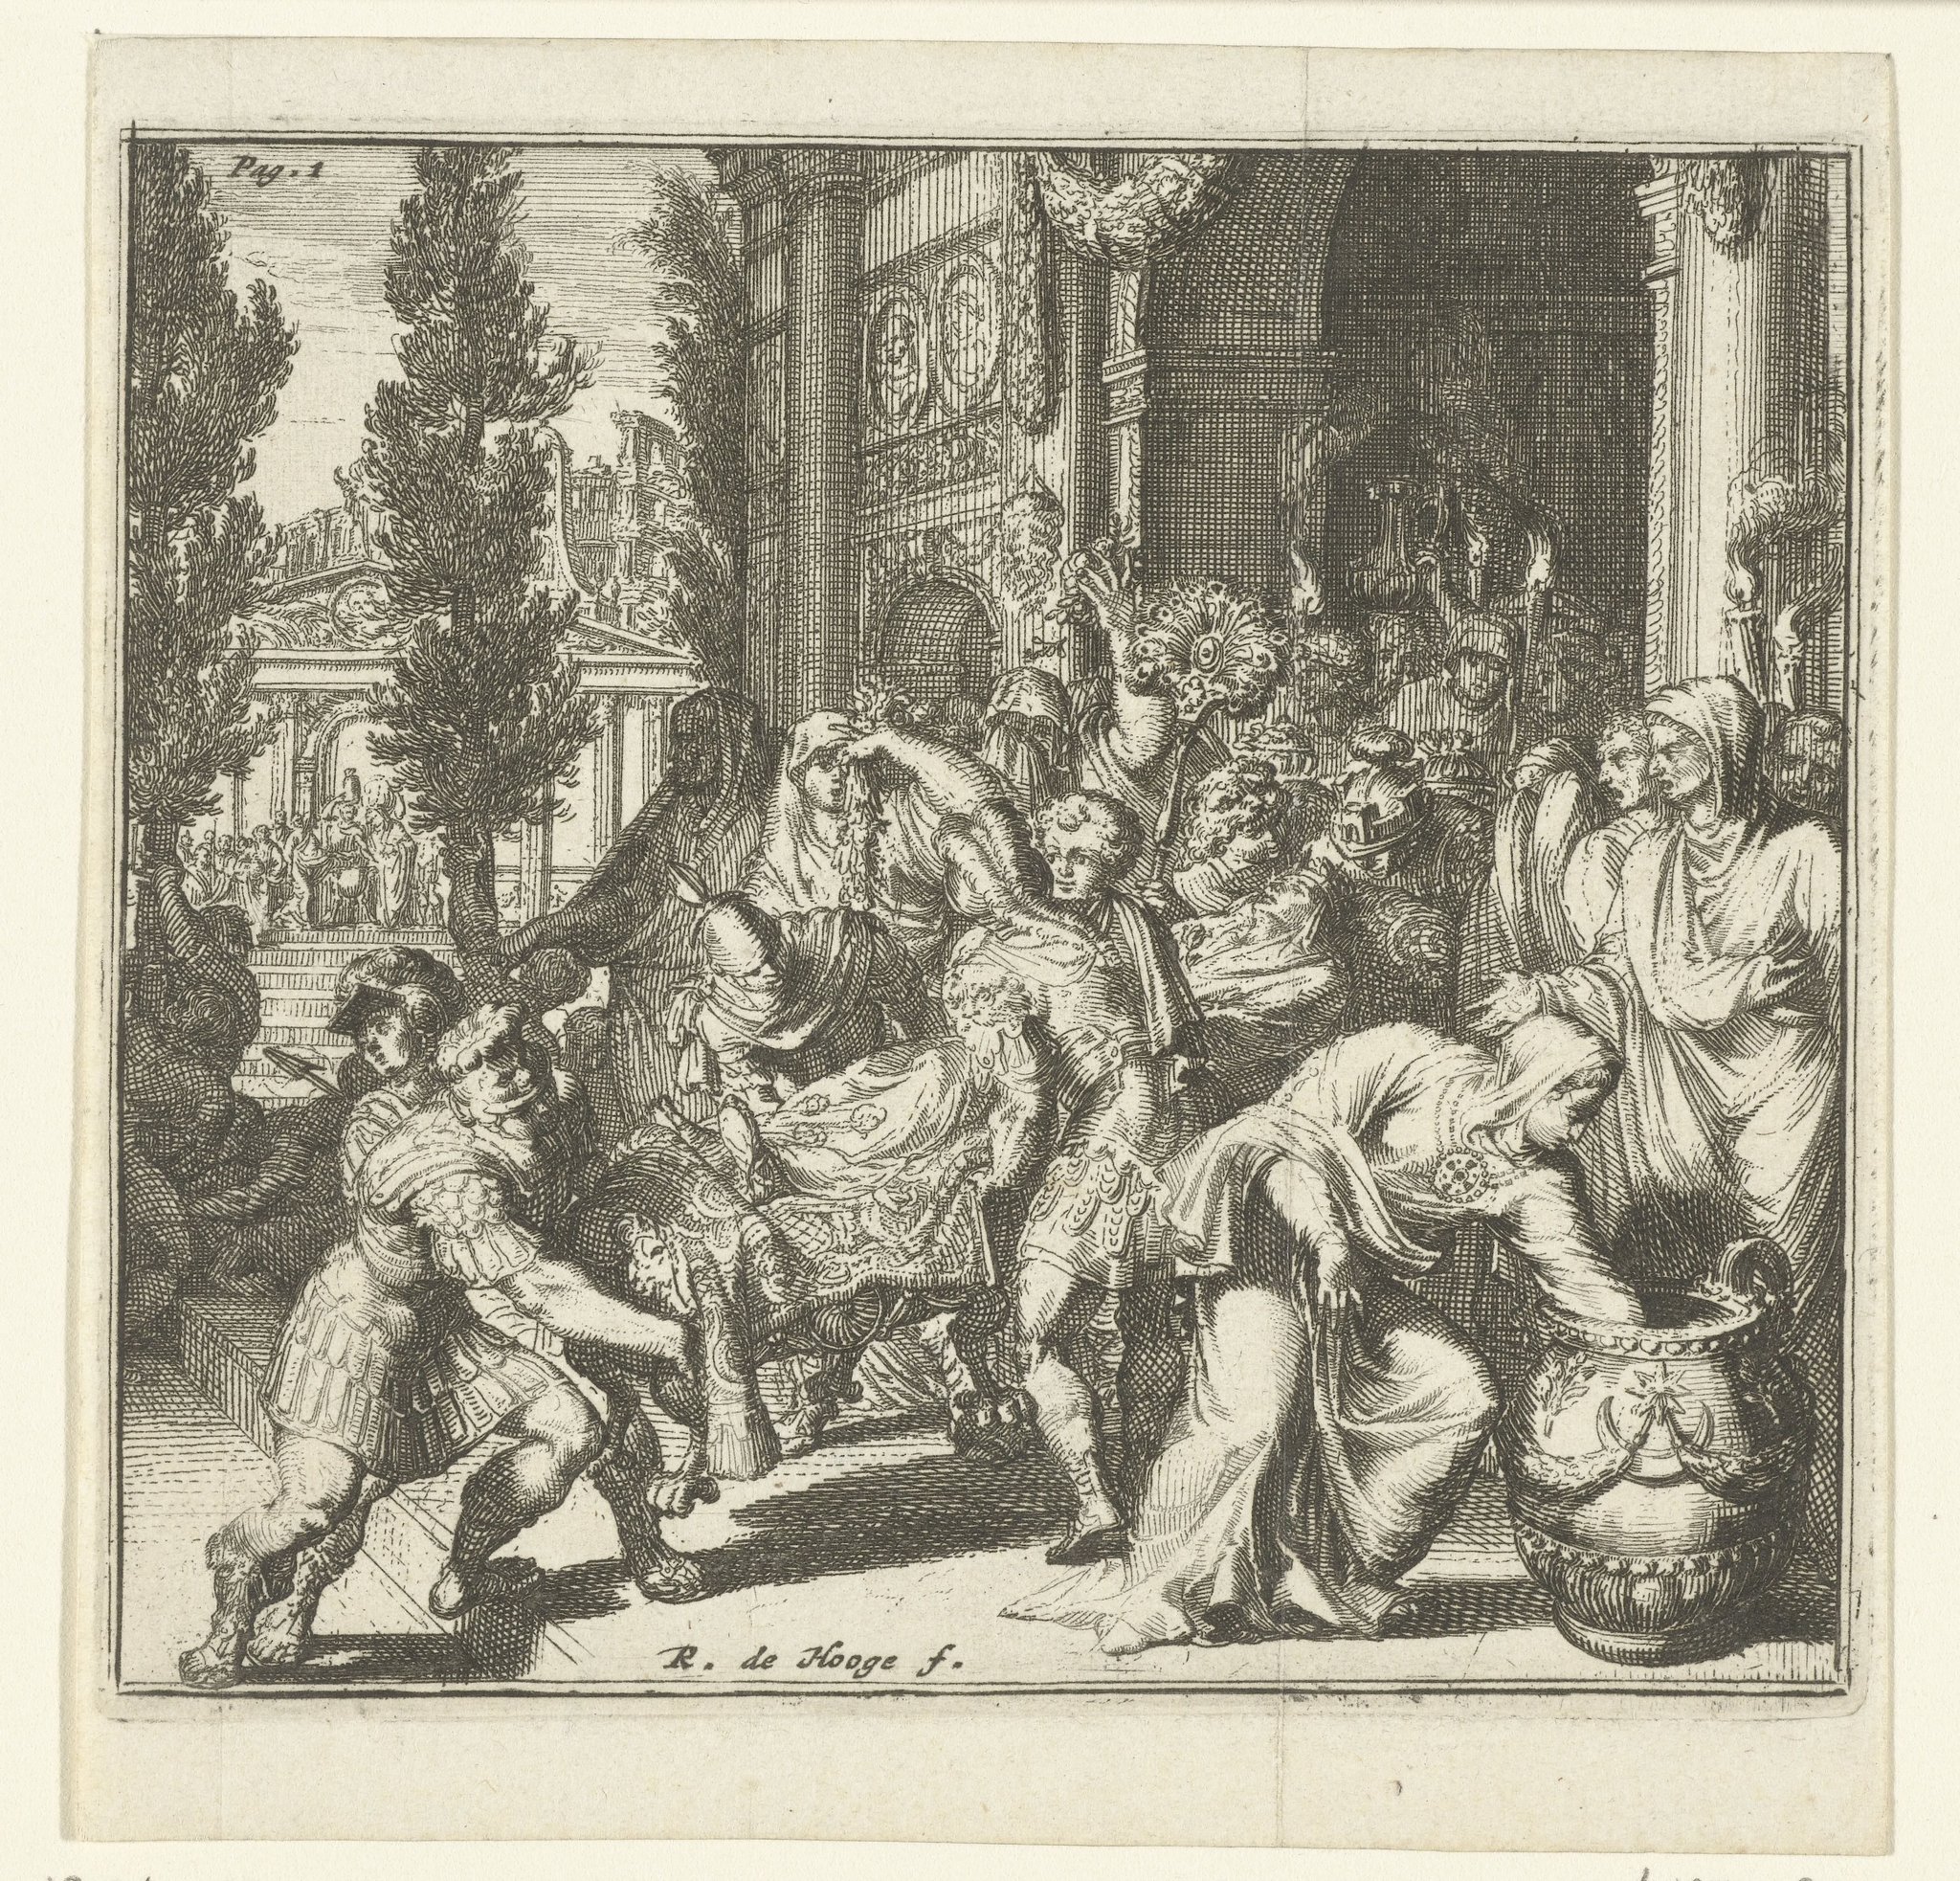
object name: print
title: Een overleden vorst wordt op een draagbaar een Romeins gebouw in- of uitgedragen.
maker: romeyn de hooghe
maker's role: draughtsman, goldsmith, painter, print maker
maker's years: 1645-1708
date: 1672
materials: paper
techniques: etching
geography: netherlands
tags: funerary ritual, ancestor cult ~ roman religion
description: Blad uit: Johannes Kirchmann, De funeribus Romanorum libri quatuor, Leiden 1672, p. 1.